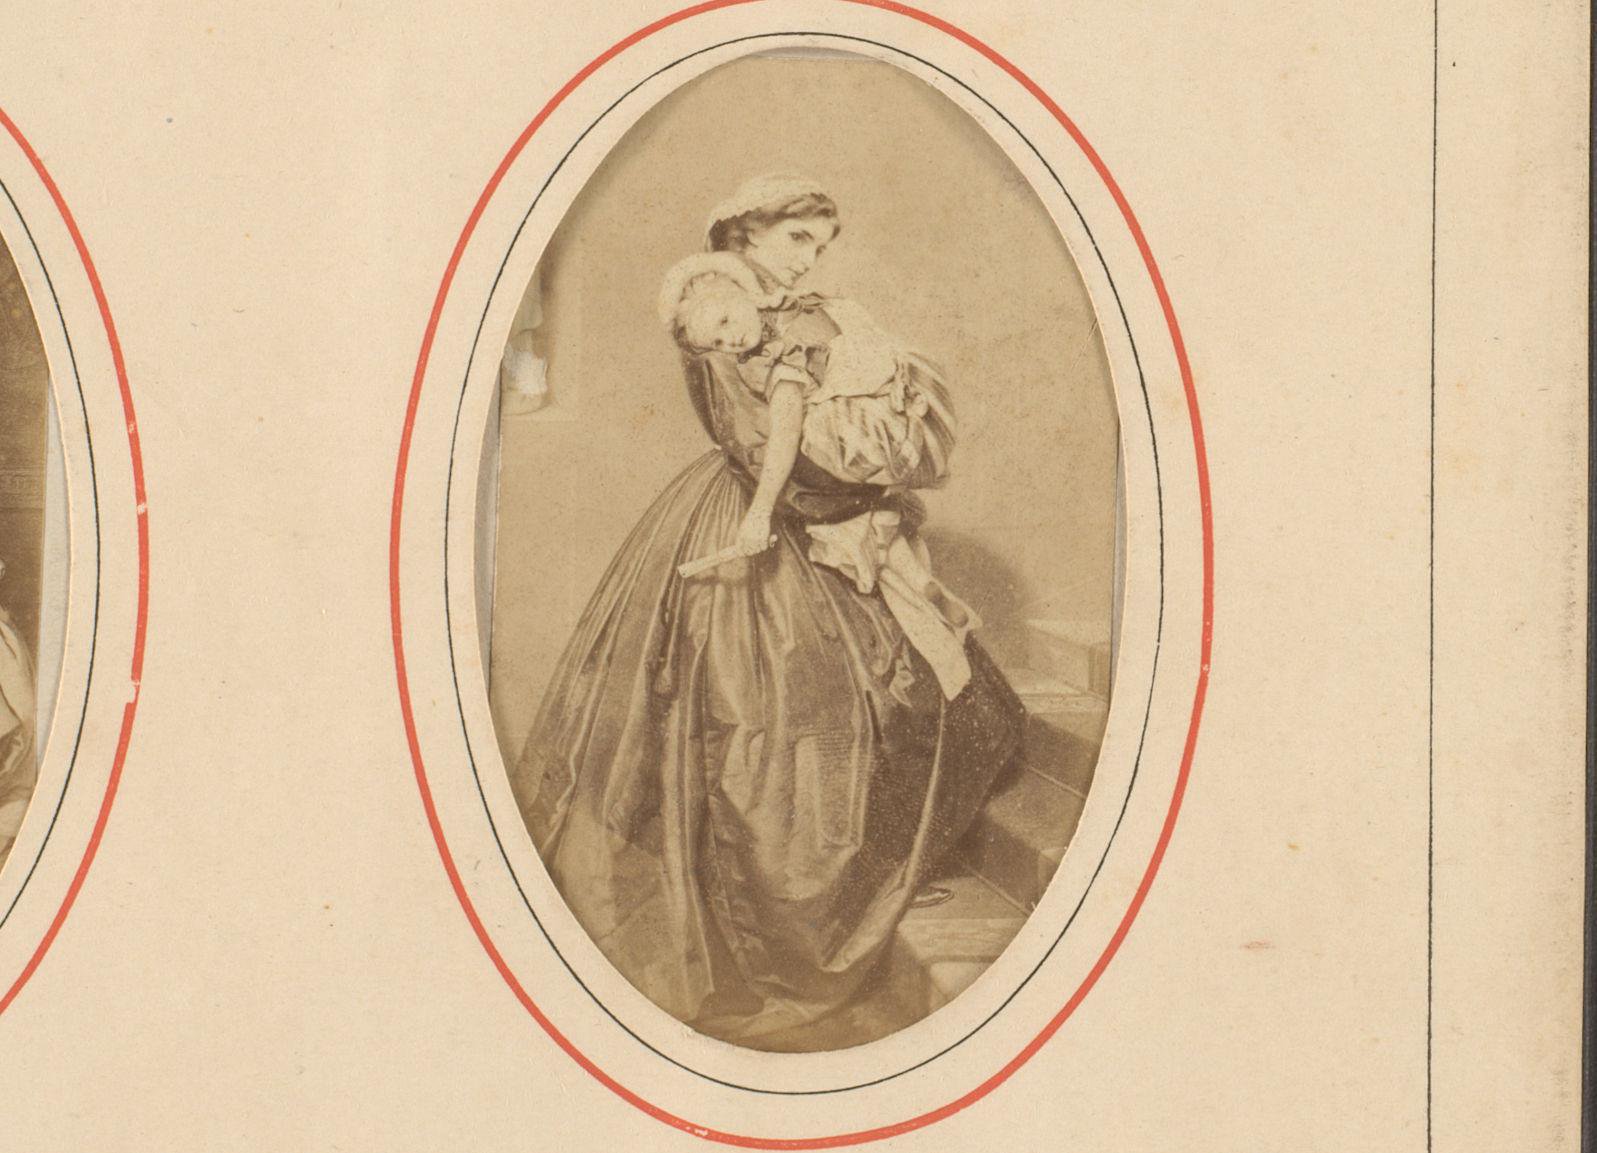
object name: reproduction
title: Miss Lily's return from the bal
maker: Anonymous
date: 1870-1890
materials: cardboard, paper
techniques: albumen print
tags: girl (child between toddler and youth)